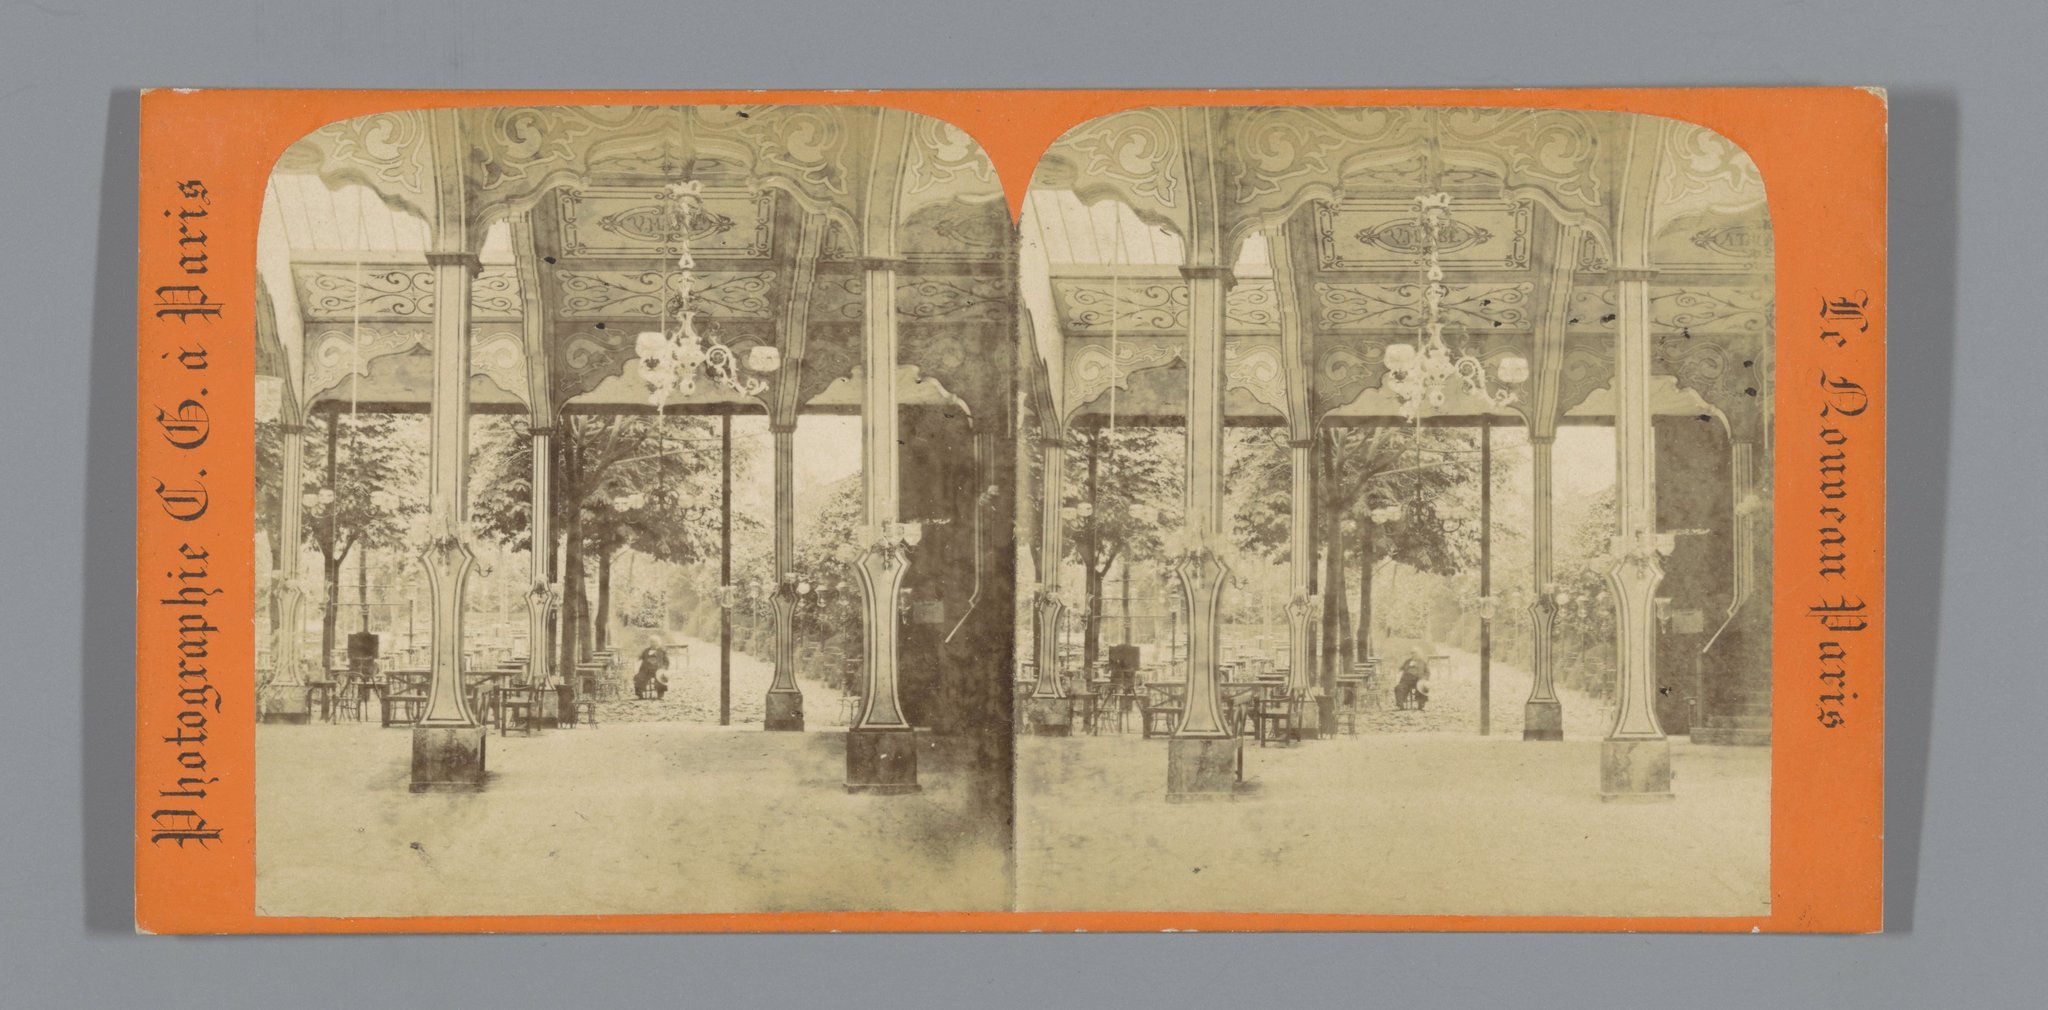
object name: stereograph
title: Bal Bullier te Parijs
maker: charles gérard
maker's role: fotograaf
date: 1850-1875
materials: cardboard, photographic support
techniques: albumen print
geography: bal bullier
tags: night-club, dance-hall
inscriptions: inscription: ‘Jardin Bullier Paris’